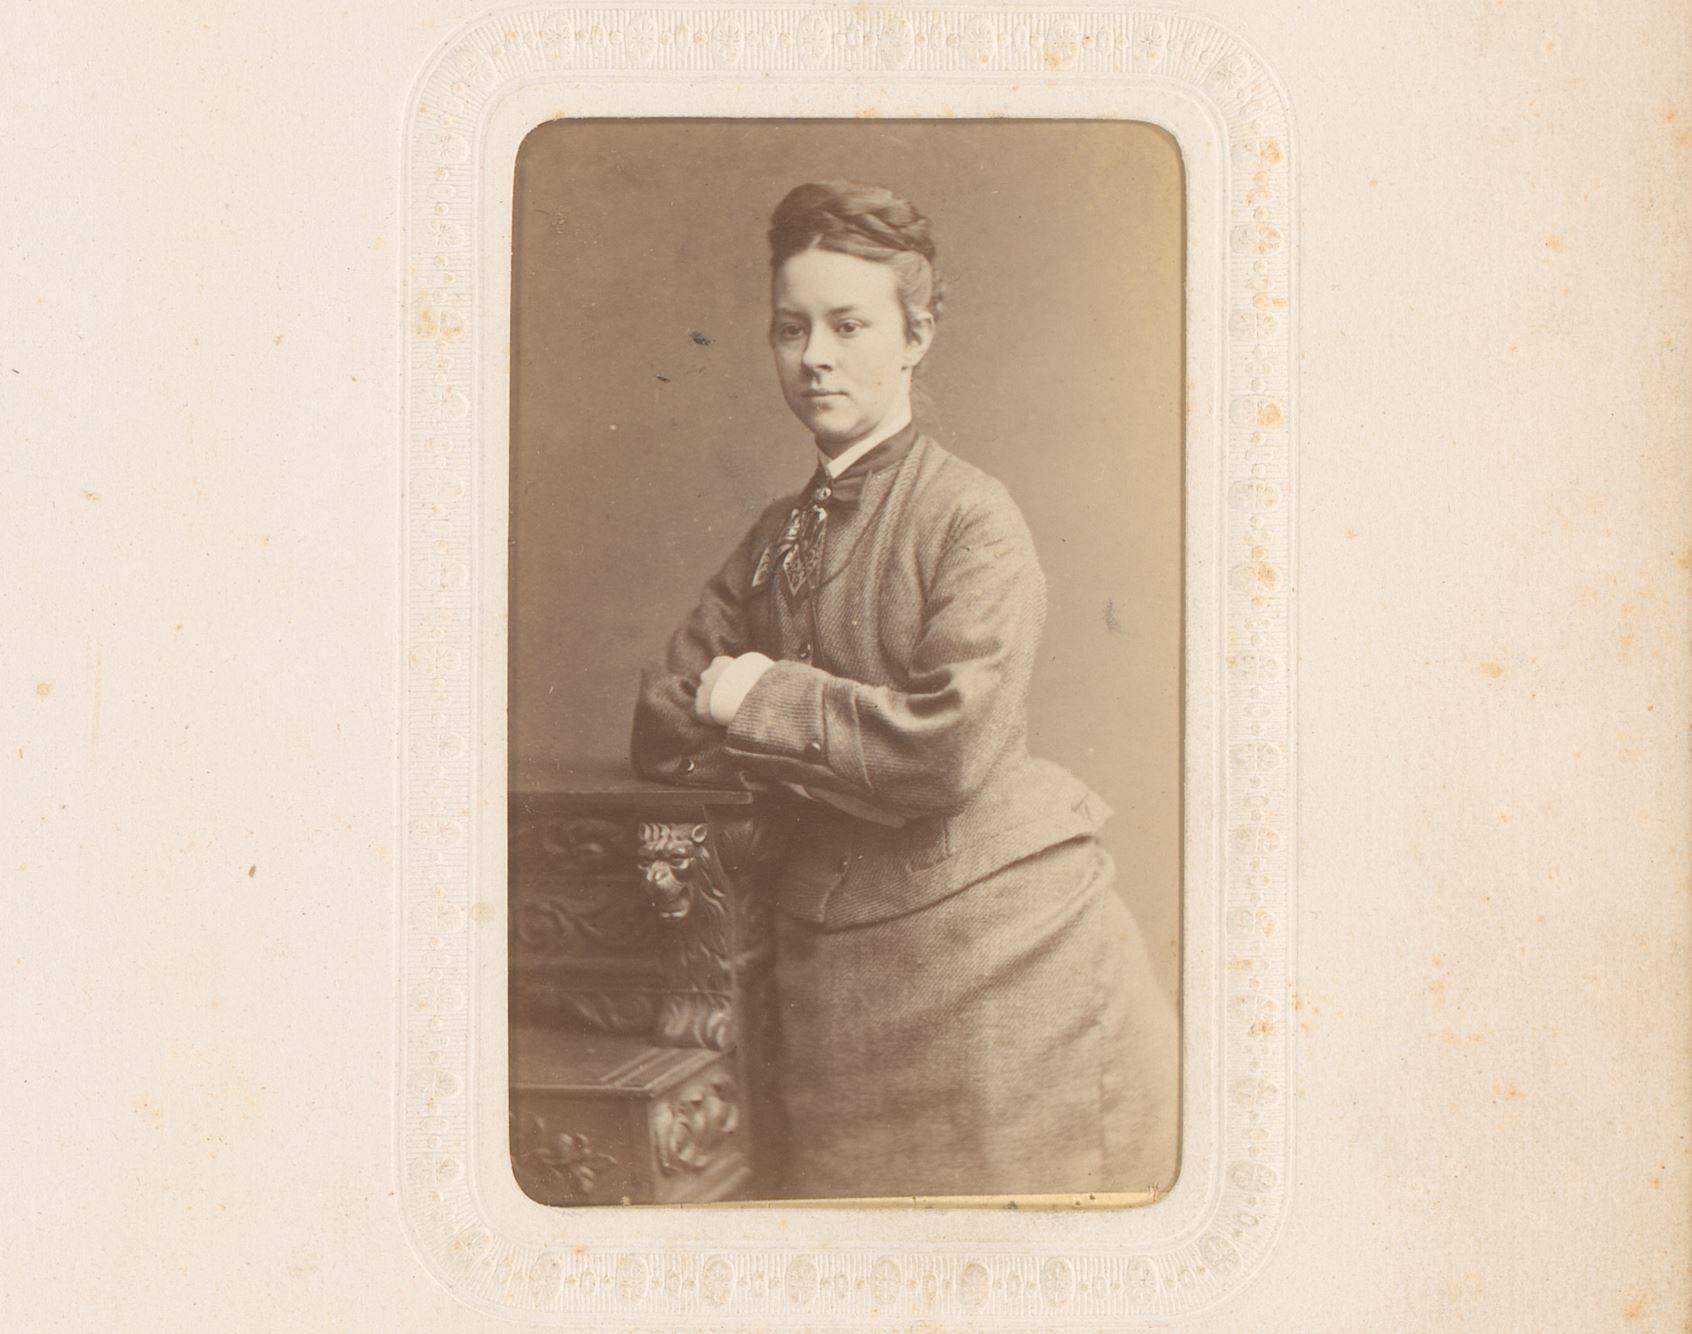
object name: album leaf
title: Portret van een jonge vrouw, leunend op een schrijftafel, aangeduid als zuster Jet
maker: Anonymous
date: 1860-1900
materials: cardboard, photographic support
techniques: albumen print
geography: netherlands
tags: writing-table, writing-desk, adolescent, young woman, maiden, historical persons - bb - woman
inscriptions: name: ‘zuster Jet’